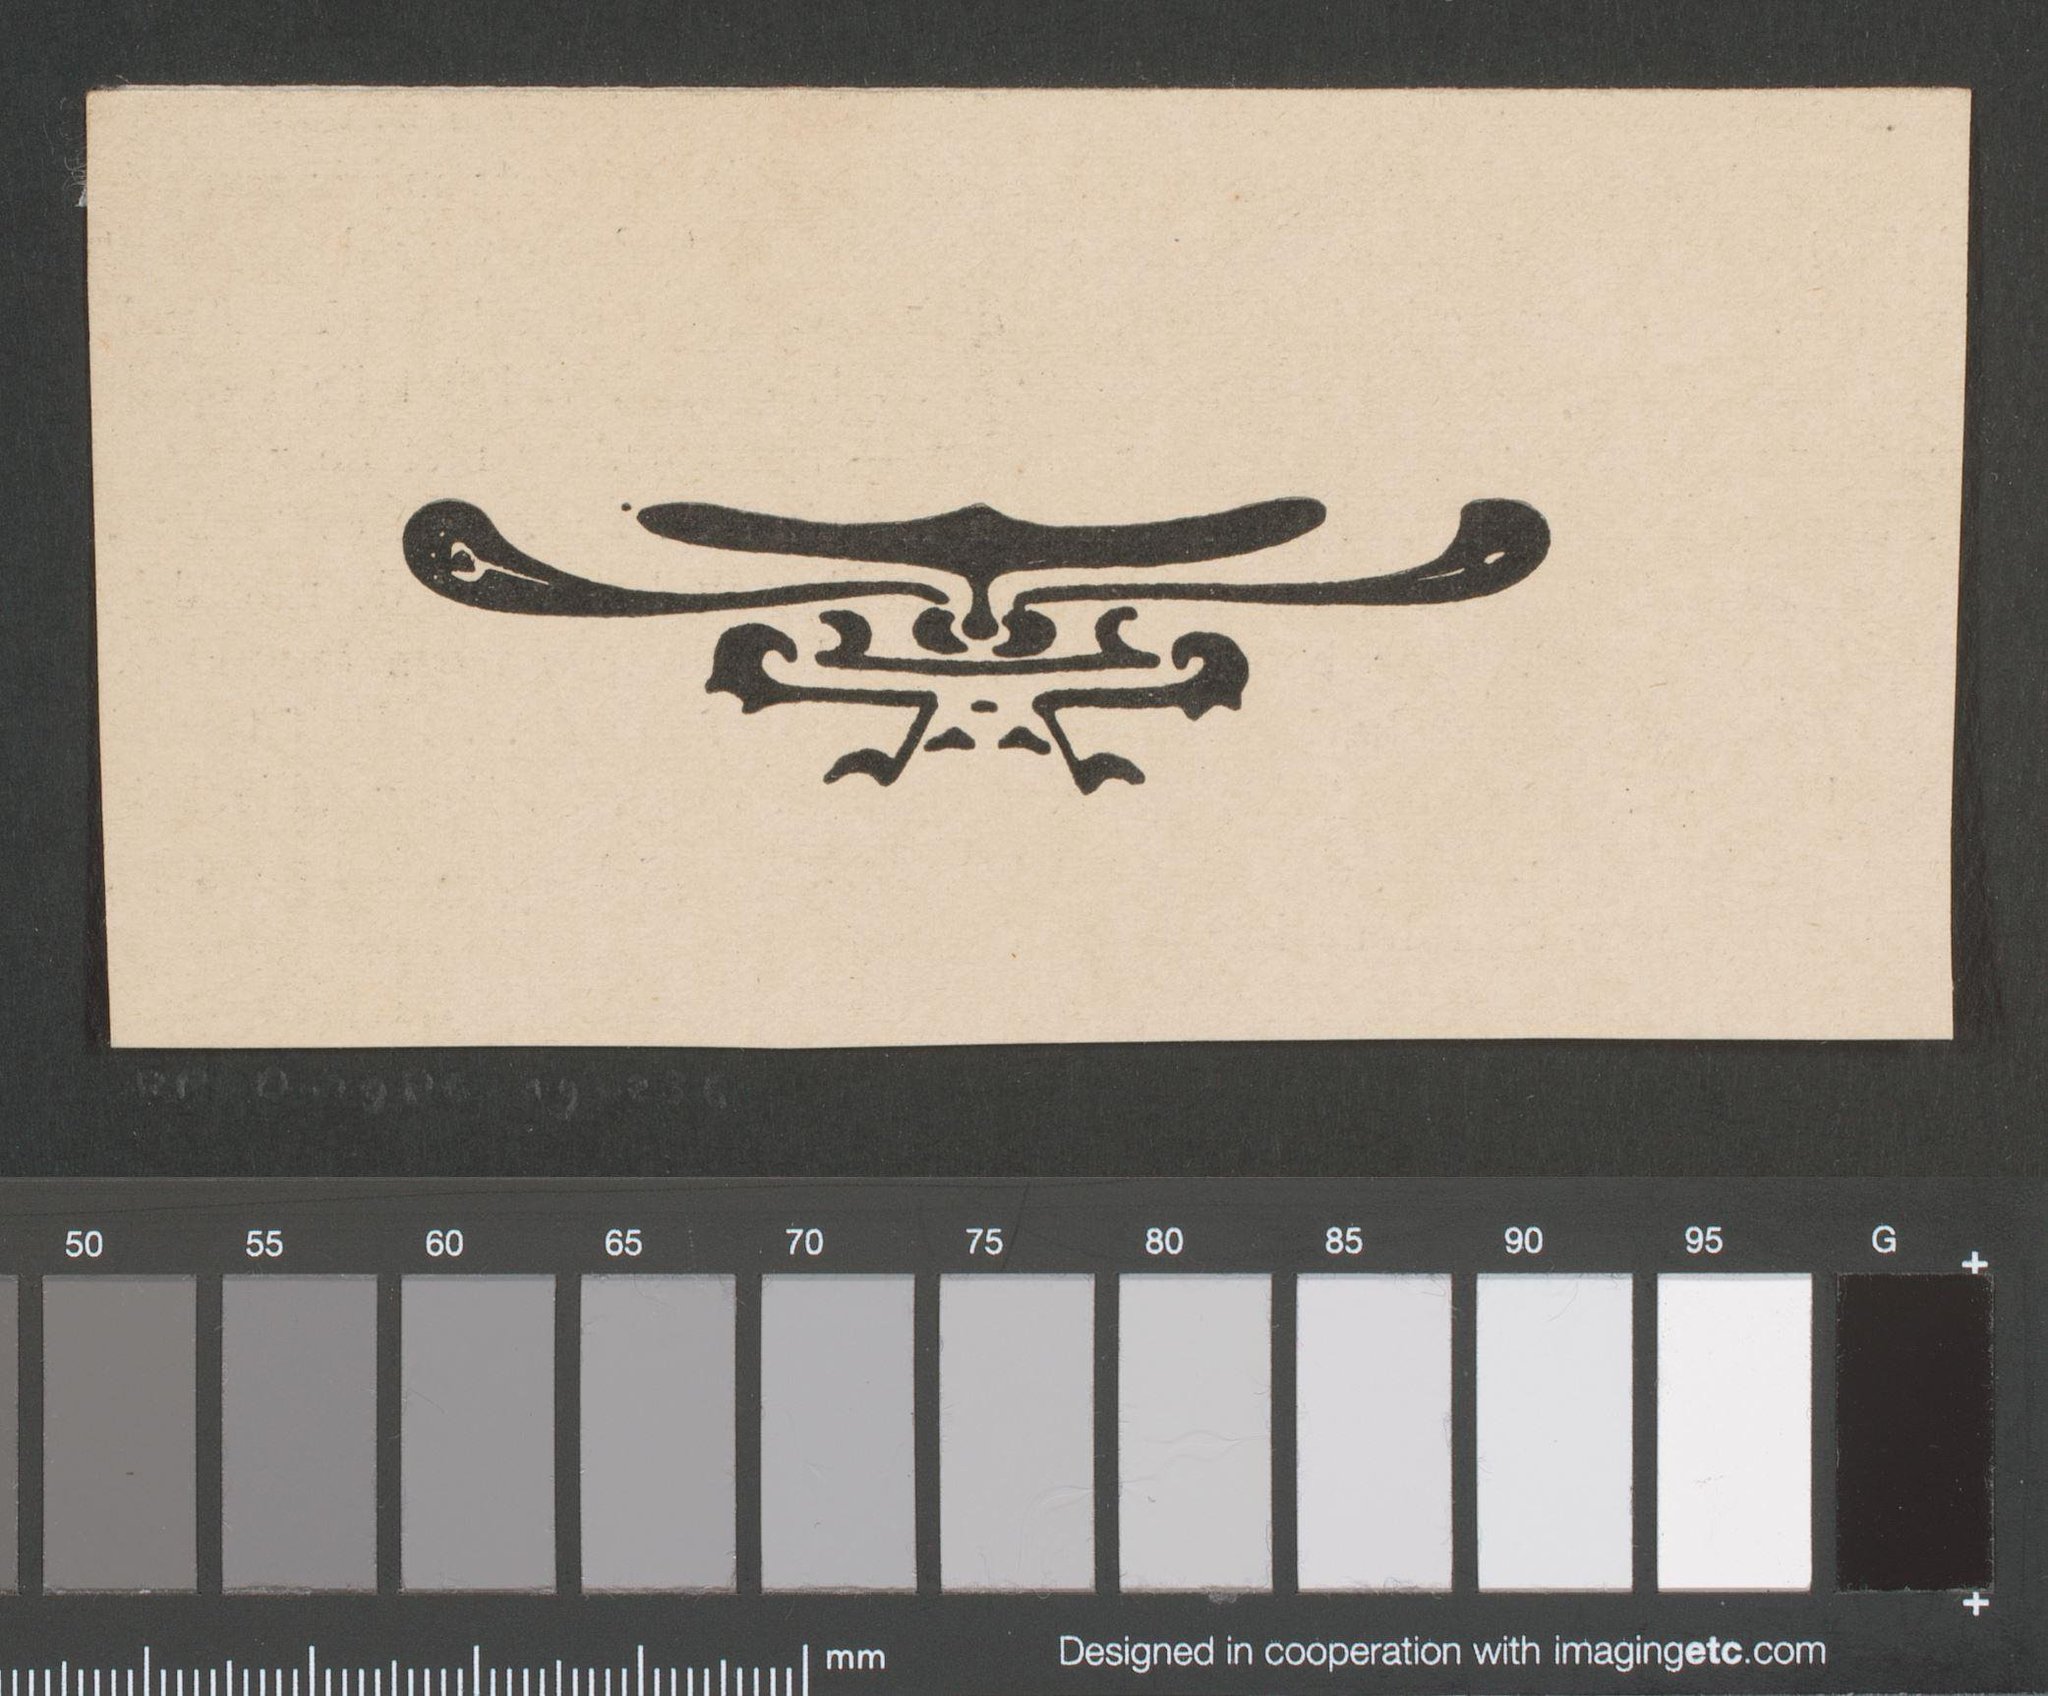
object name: photomechanical print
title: Vignet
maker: reinier willem petrus de vries (1874-1953)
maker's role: draughtsman, print maker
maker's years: 1874-1953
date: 1884-1952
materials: paper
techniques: printing block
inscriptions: collector's mark: ‘R:MVS.’